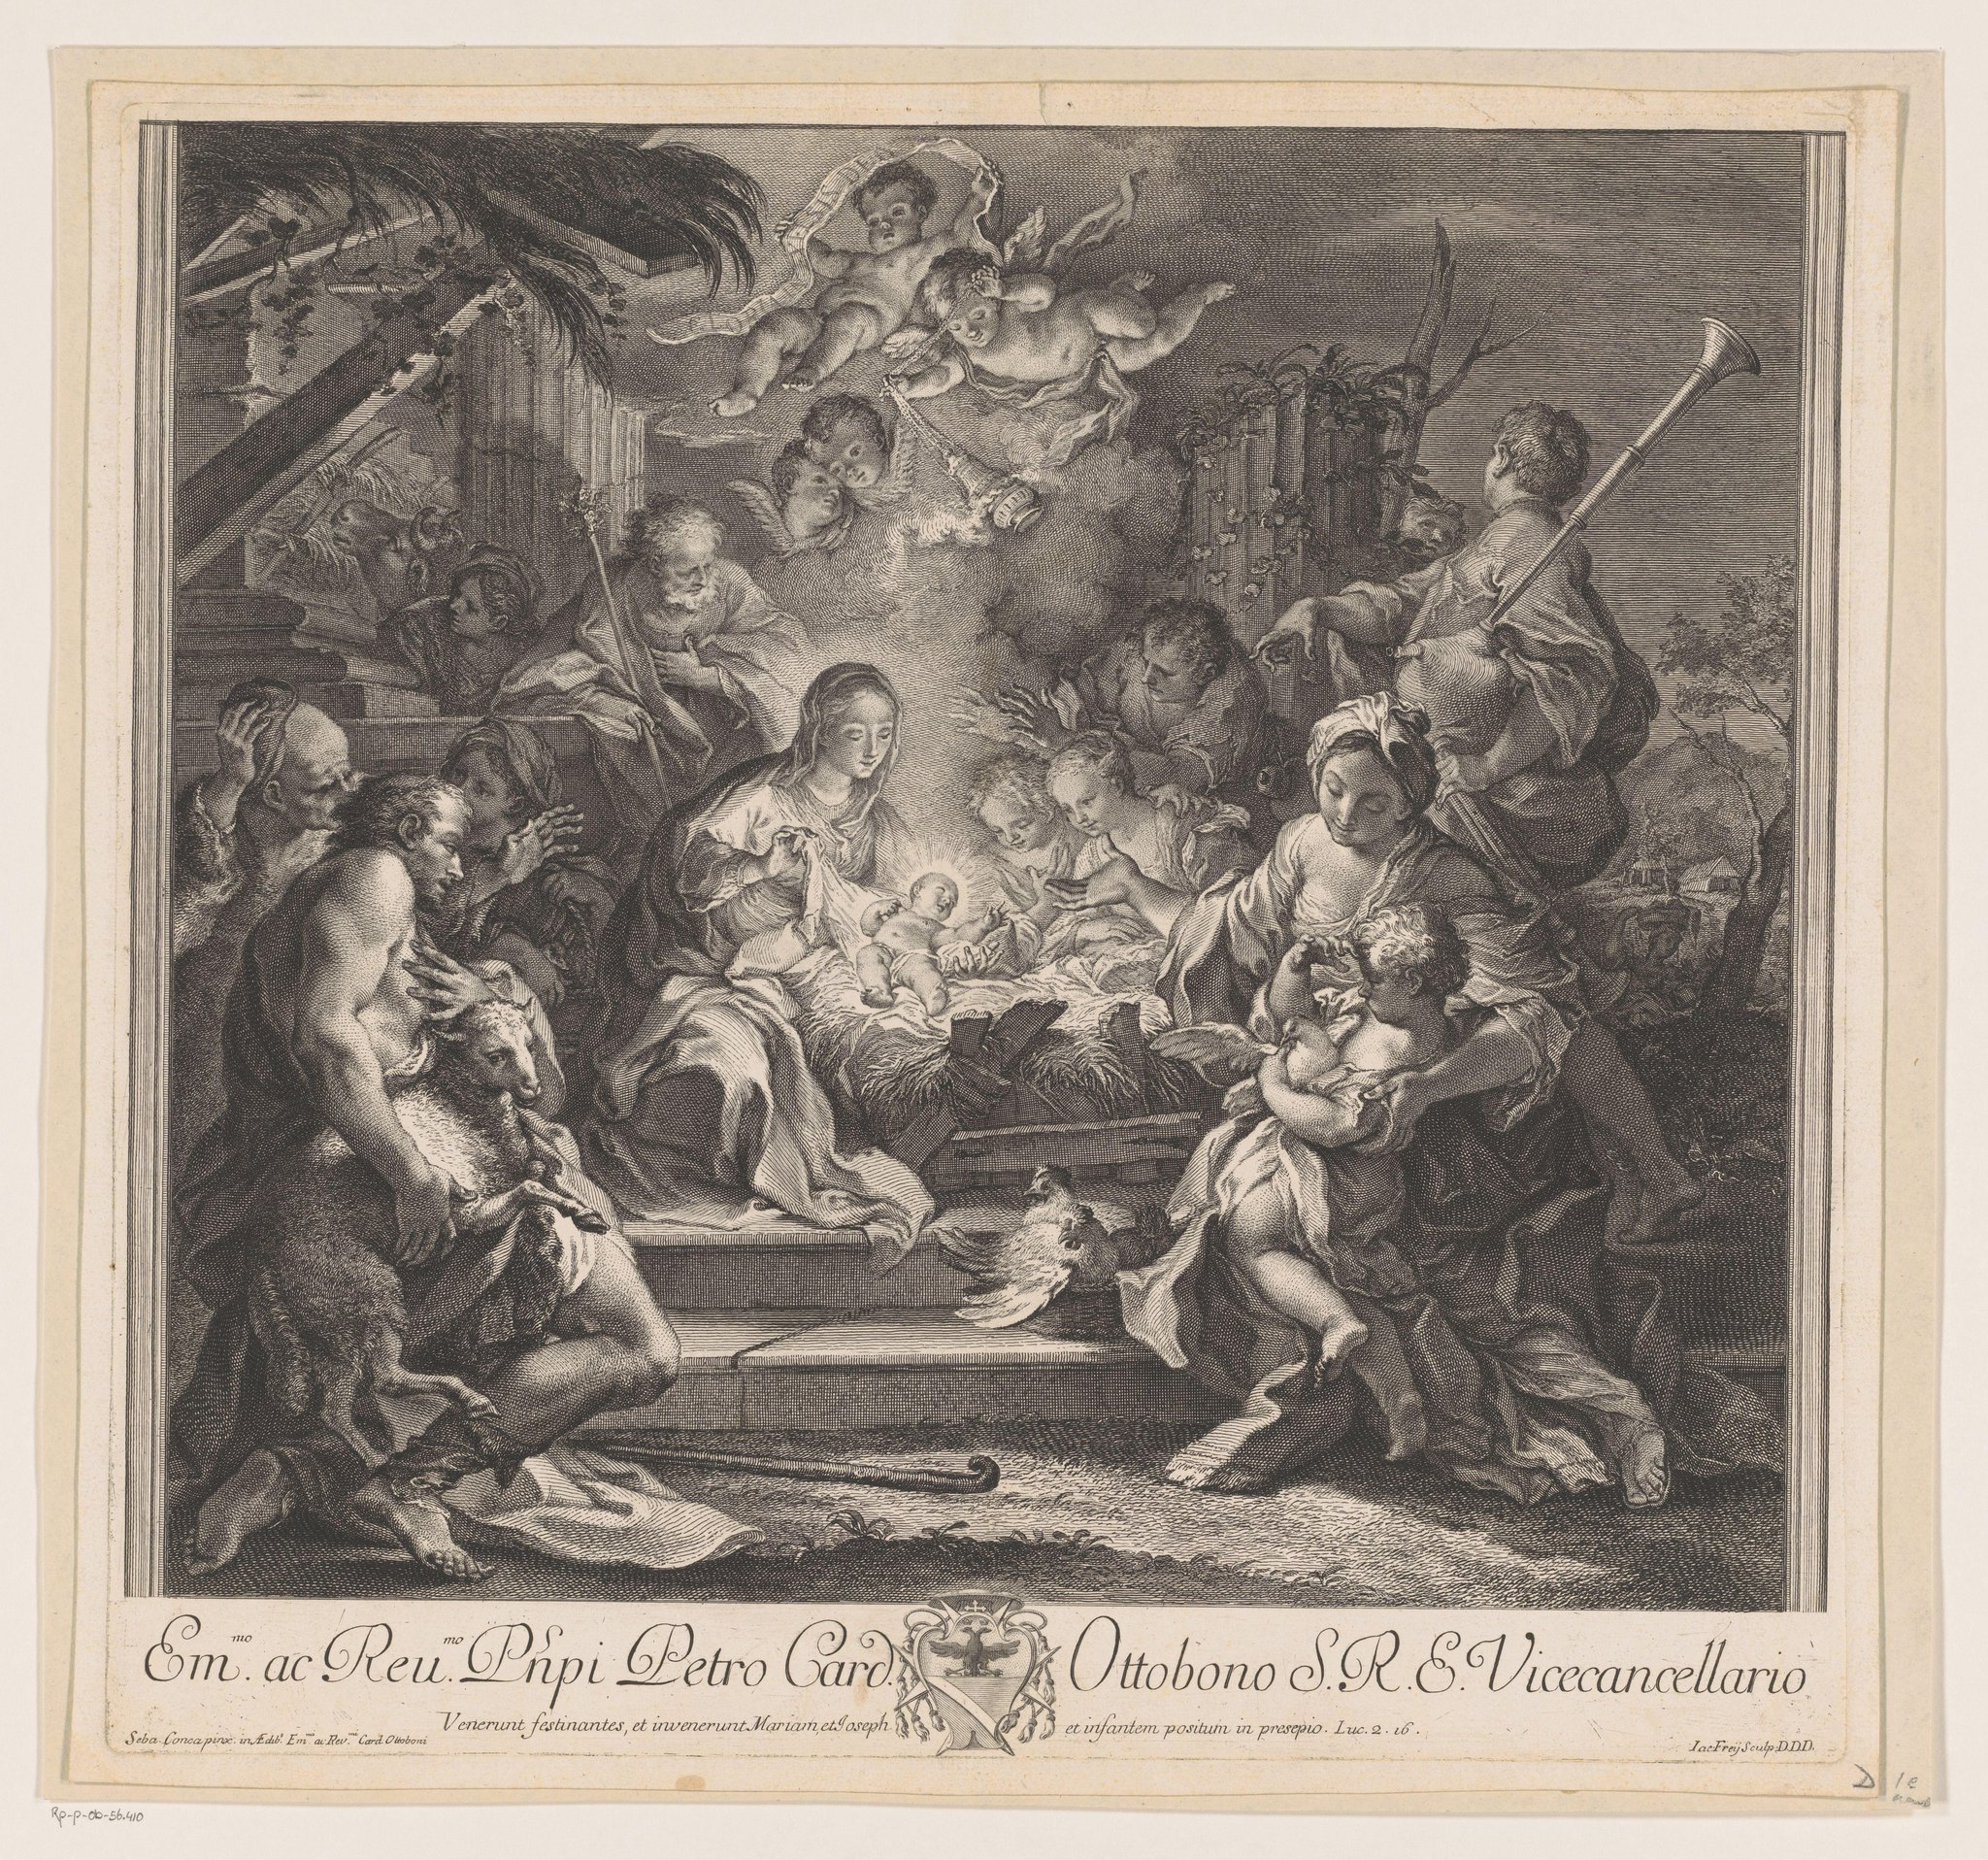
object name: print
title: Aanbidding door de herders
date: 1720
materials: paper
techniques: engraving, etching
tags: adoration of the christ-child ~ christ's birth, armorial bearing, heraldry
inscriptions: collector's mark: Lugt 240